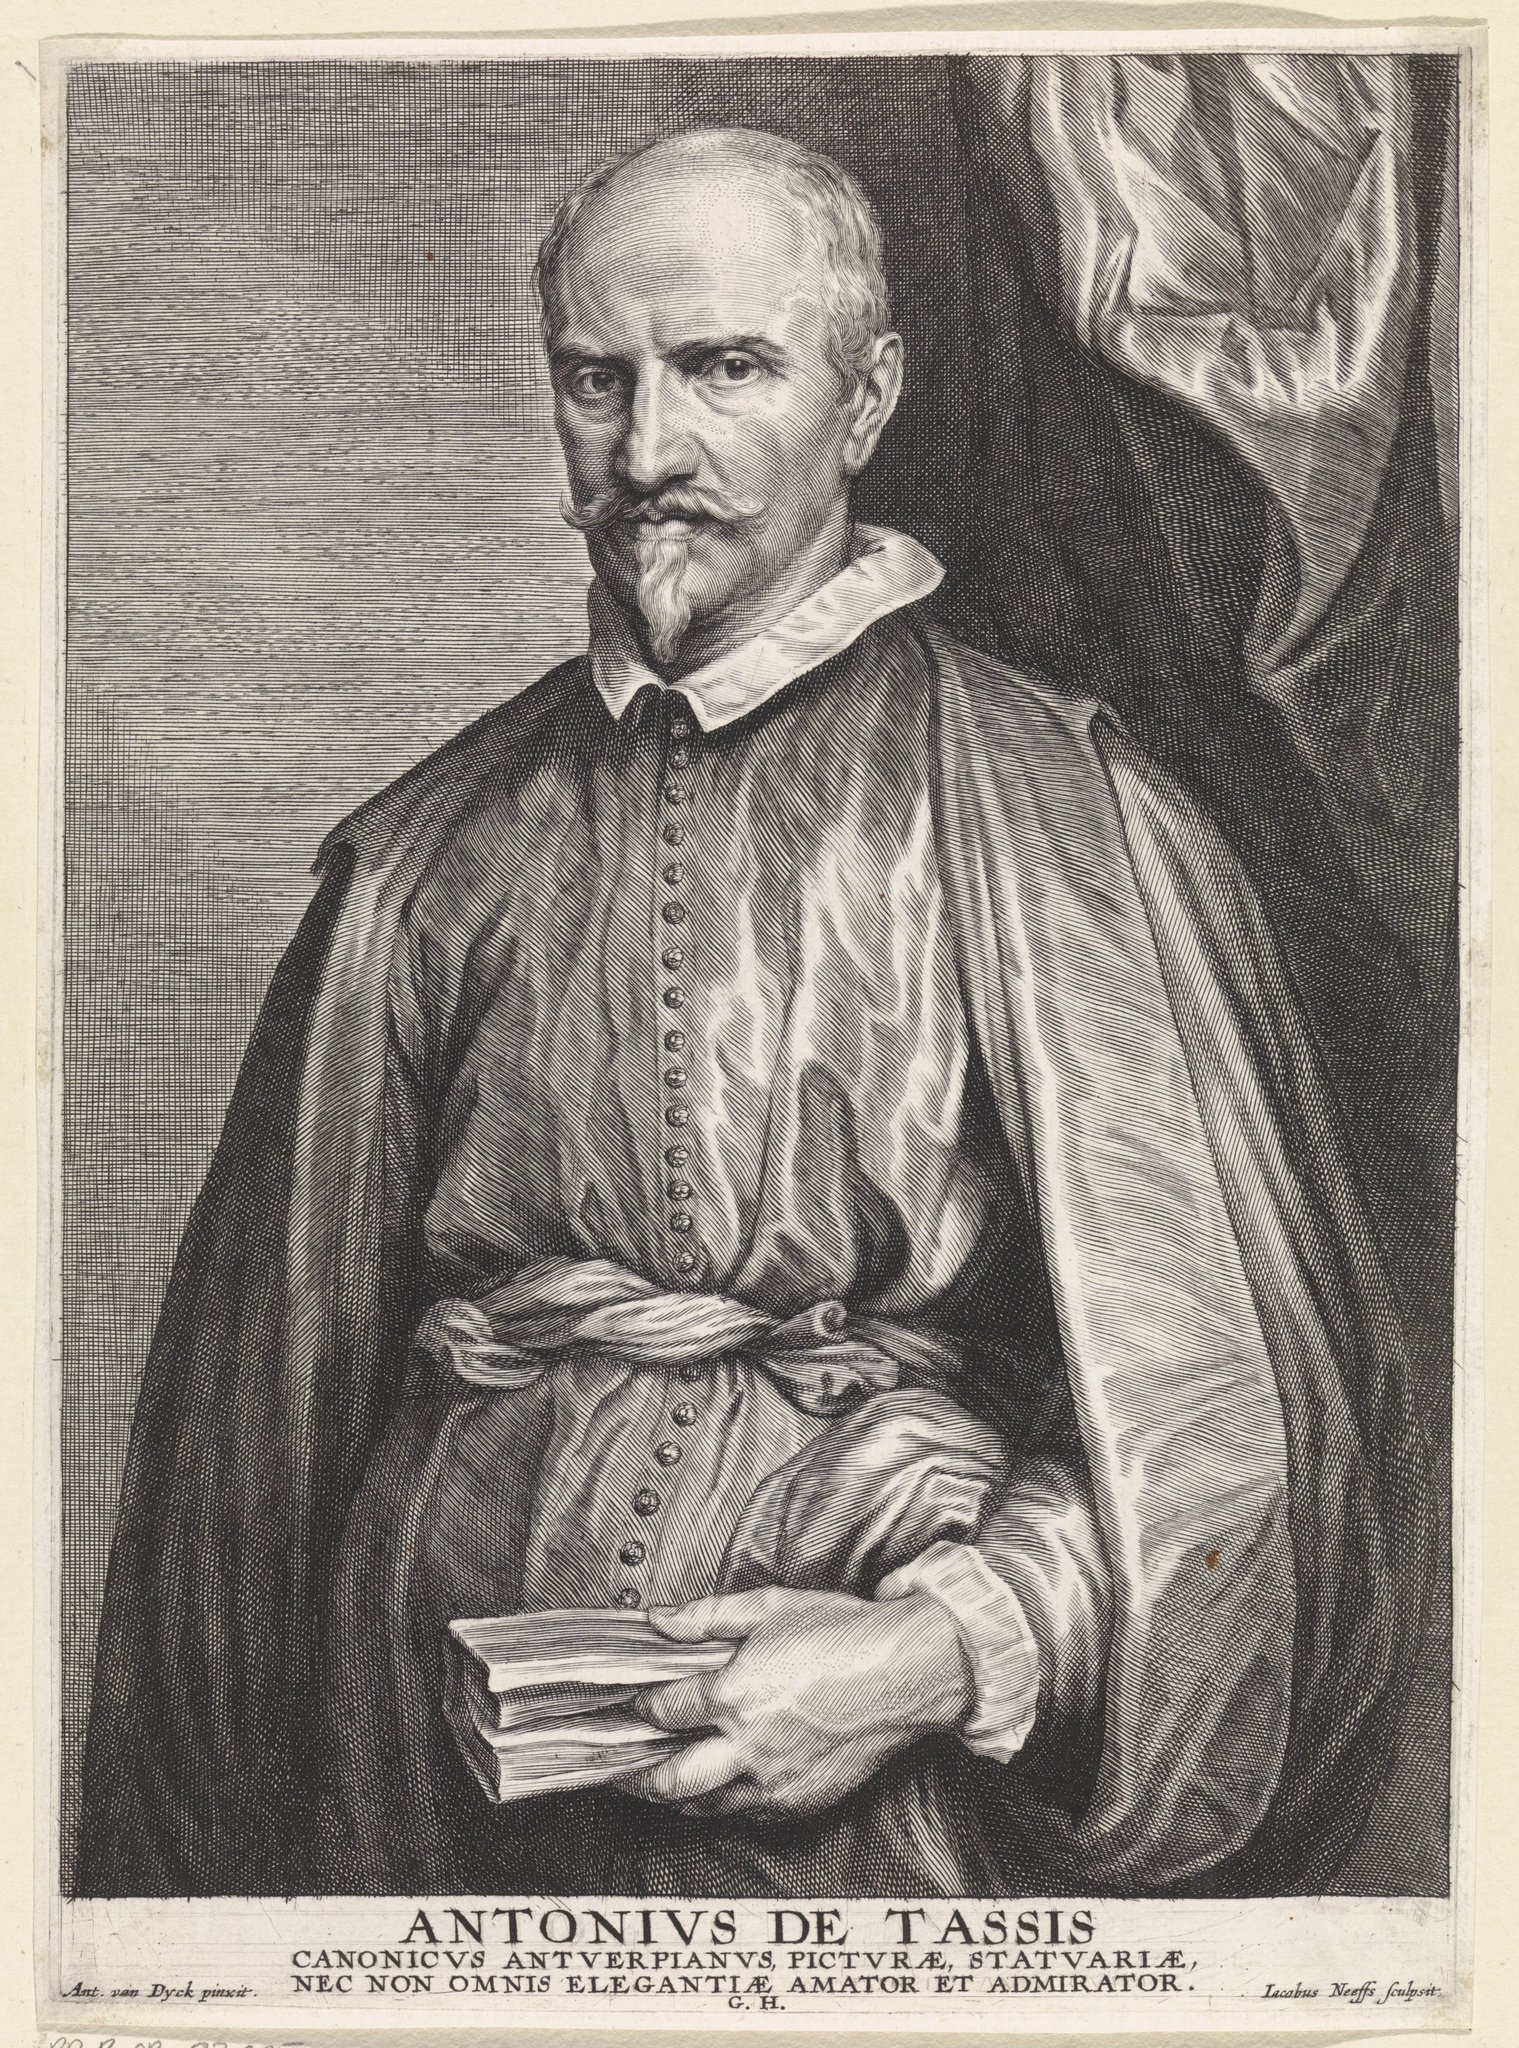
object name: print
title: Portret van Antonio de Tassis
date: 1626-1680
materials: paper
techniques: engraving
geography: antwerp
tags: antwerp, antonio de tassis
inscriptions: collector's mark: Lugt 240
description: Antonio de Tassis, staande en gekleed in een wijde mantel, met in zijn rechterhand een boek. Portret ten halven lijve naar links. Onderaan in de marge een tweeregelige tekst in het Latijn.